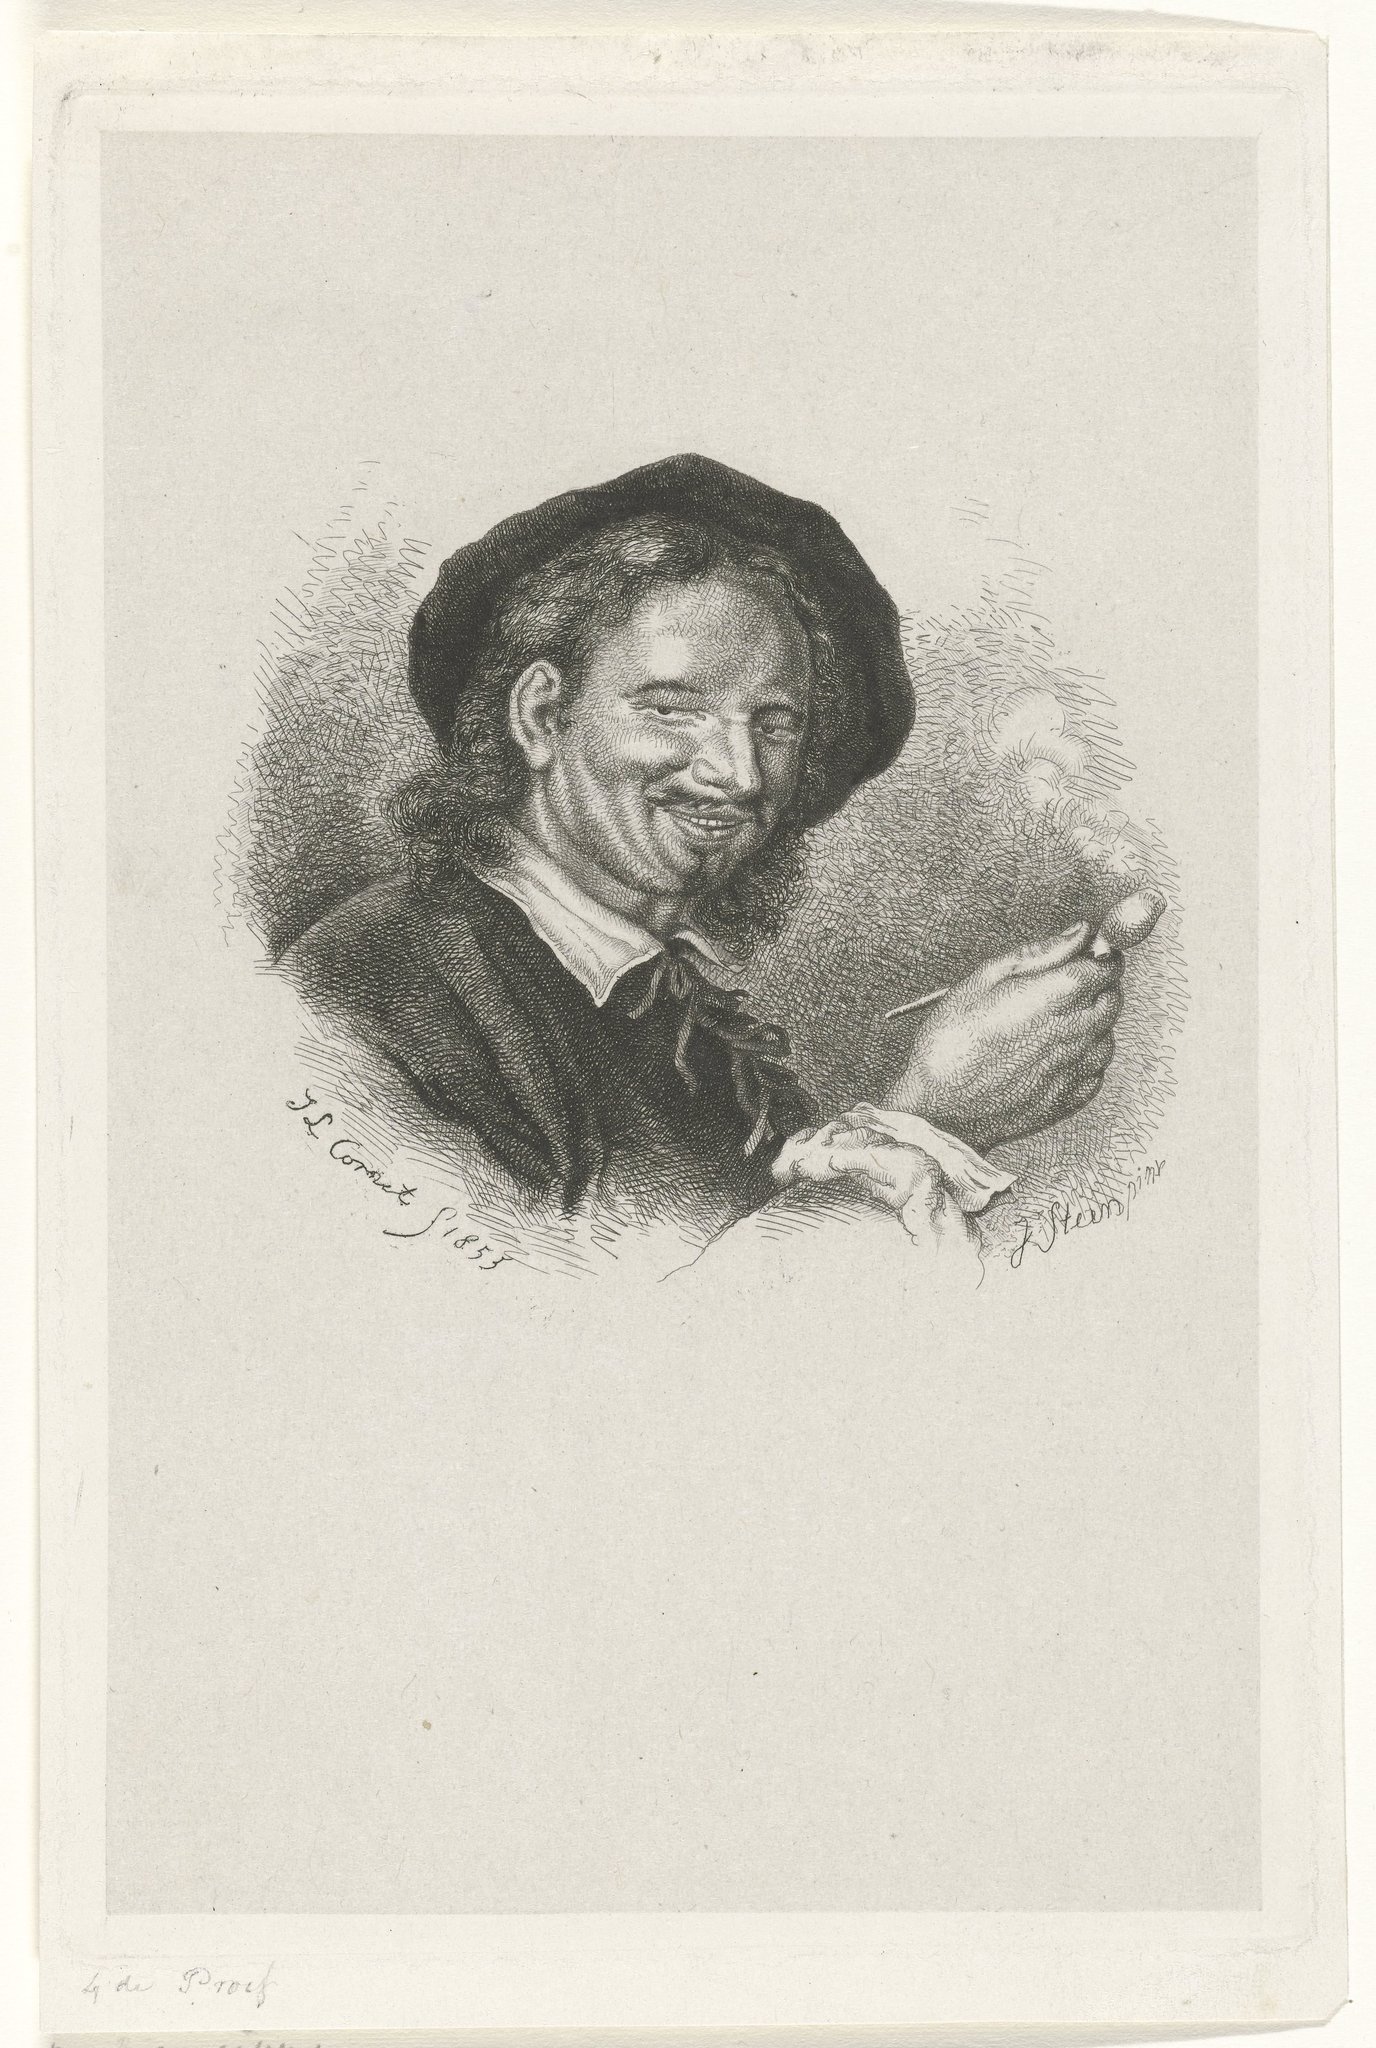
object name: print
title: Portret van Jan Steen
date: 1854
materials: paper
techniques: etching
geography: leiden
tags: leiden, painter, jan havicksz. steen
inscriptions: caption: ‘4ste proef’, collector's mark: Lugt 2228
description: Portret van de schilder Jan Steen. Steen draagt een hoed en heeft een pijp in de hand. Buste naar rechts.